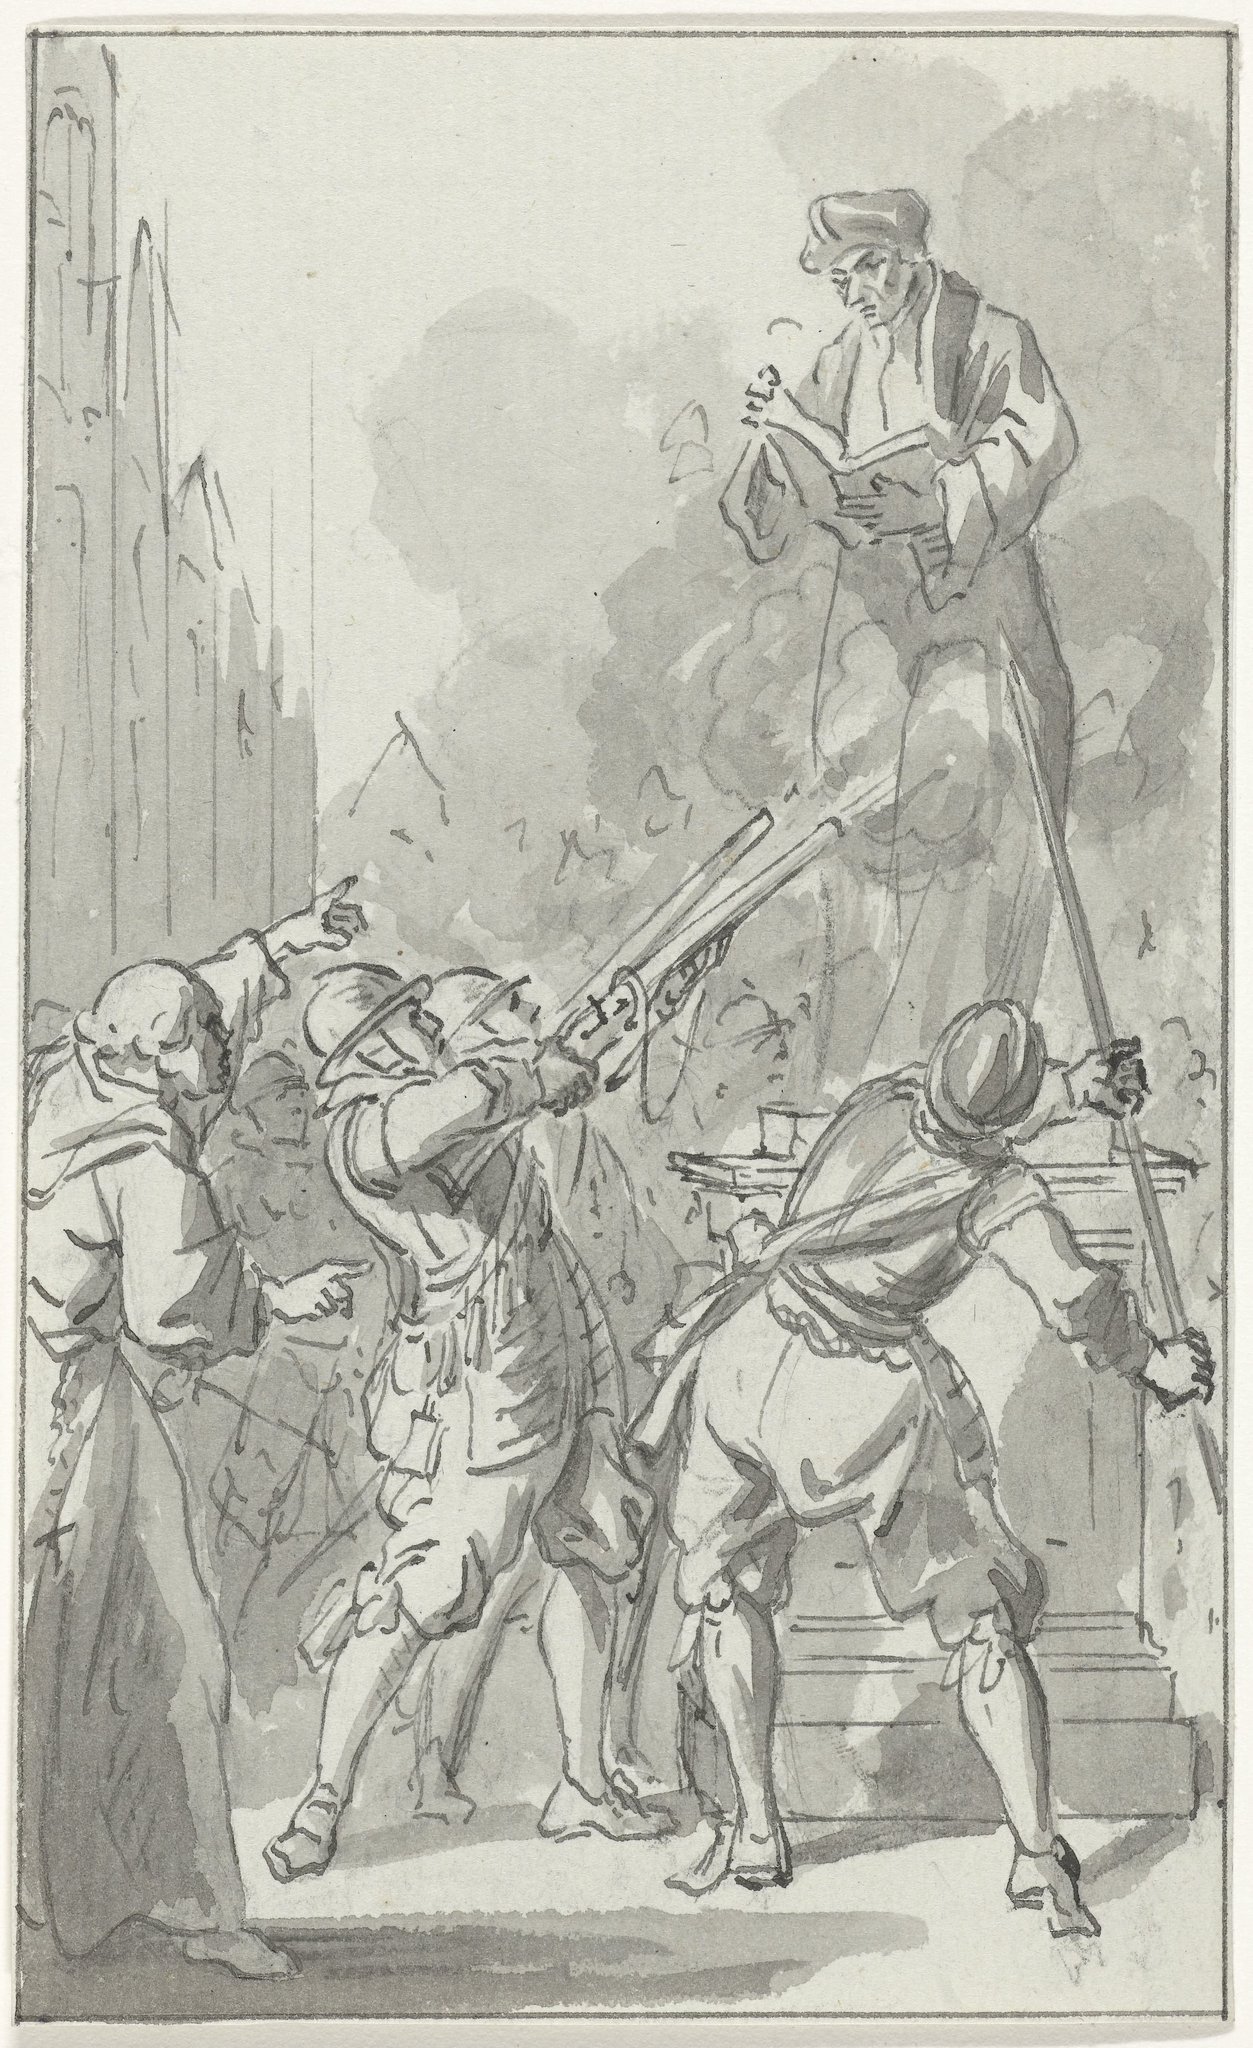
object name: design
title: Het beeld van Erasmus te Rotterdam beschoten door de Spanjaarden, 1572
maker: jacobus buys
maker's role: draughtsman, print maker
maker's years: 1724-1801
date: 1789-1791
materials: ink, paper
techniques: brush, pen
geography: netherlands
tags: rotterdam, desiderius erasmus, the (nude) human figure; 'corpo humano' (ripa), piece of sculpture, reproduction of a piece of sculpture, monument, statue, iconoclasm, historical events and situations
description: Spaanse soldaten onder Bossu beschieten het standbeeld van Erasmus te Rotterdam, 1572. Links een gebarende priester. Ontwerp voor een prent.